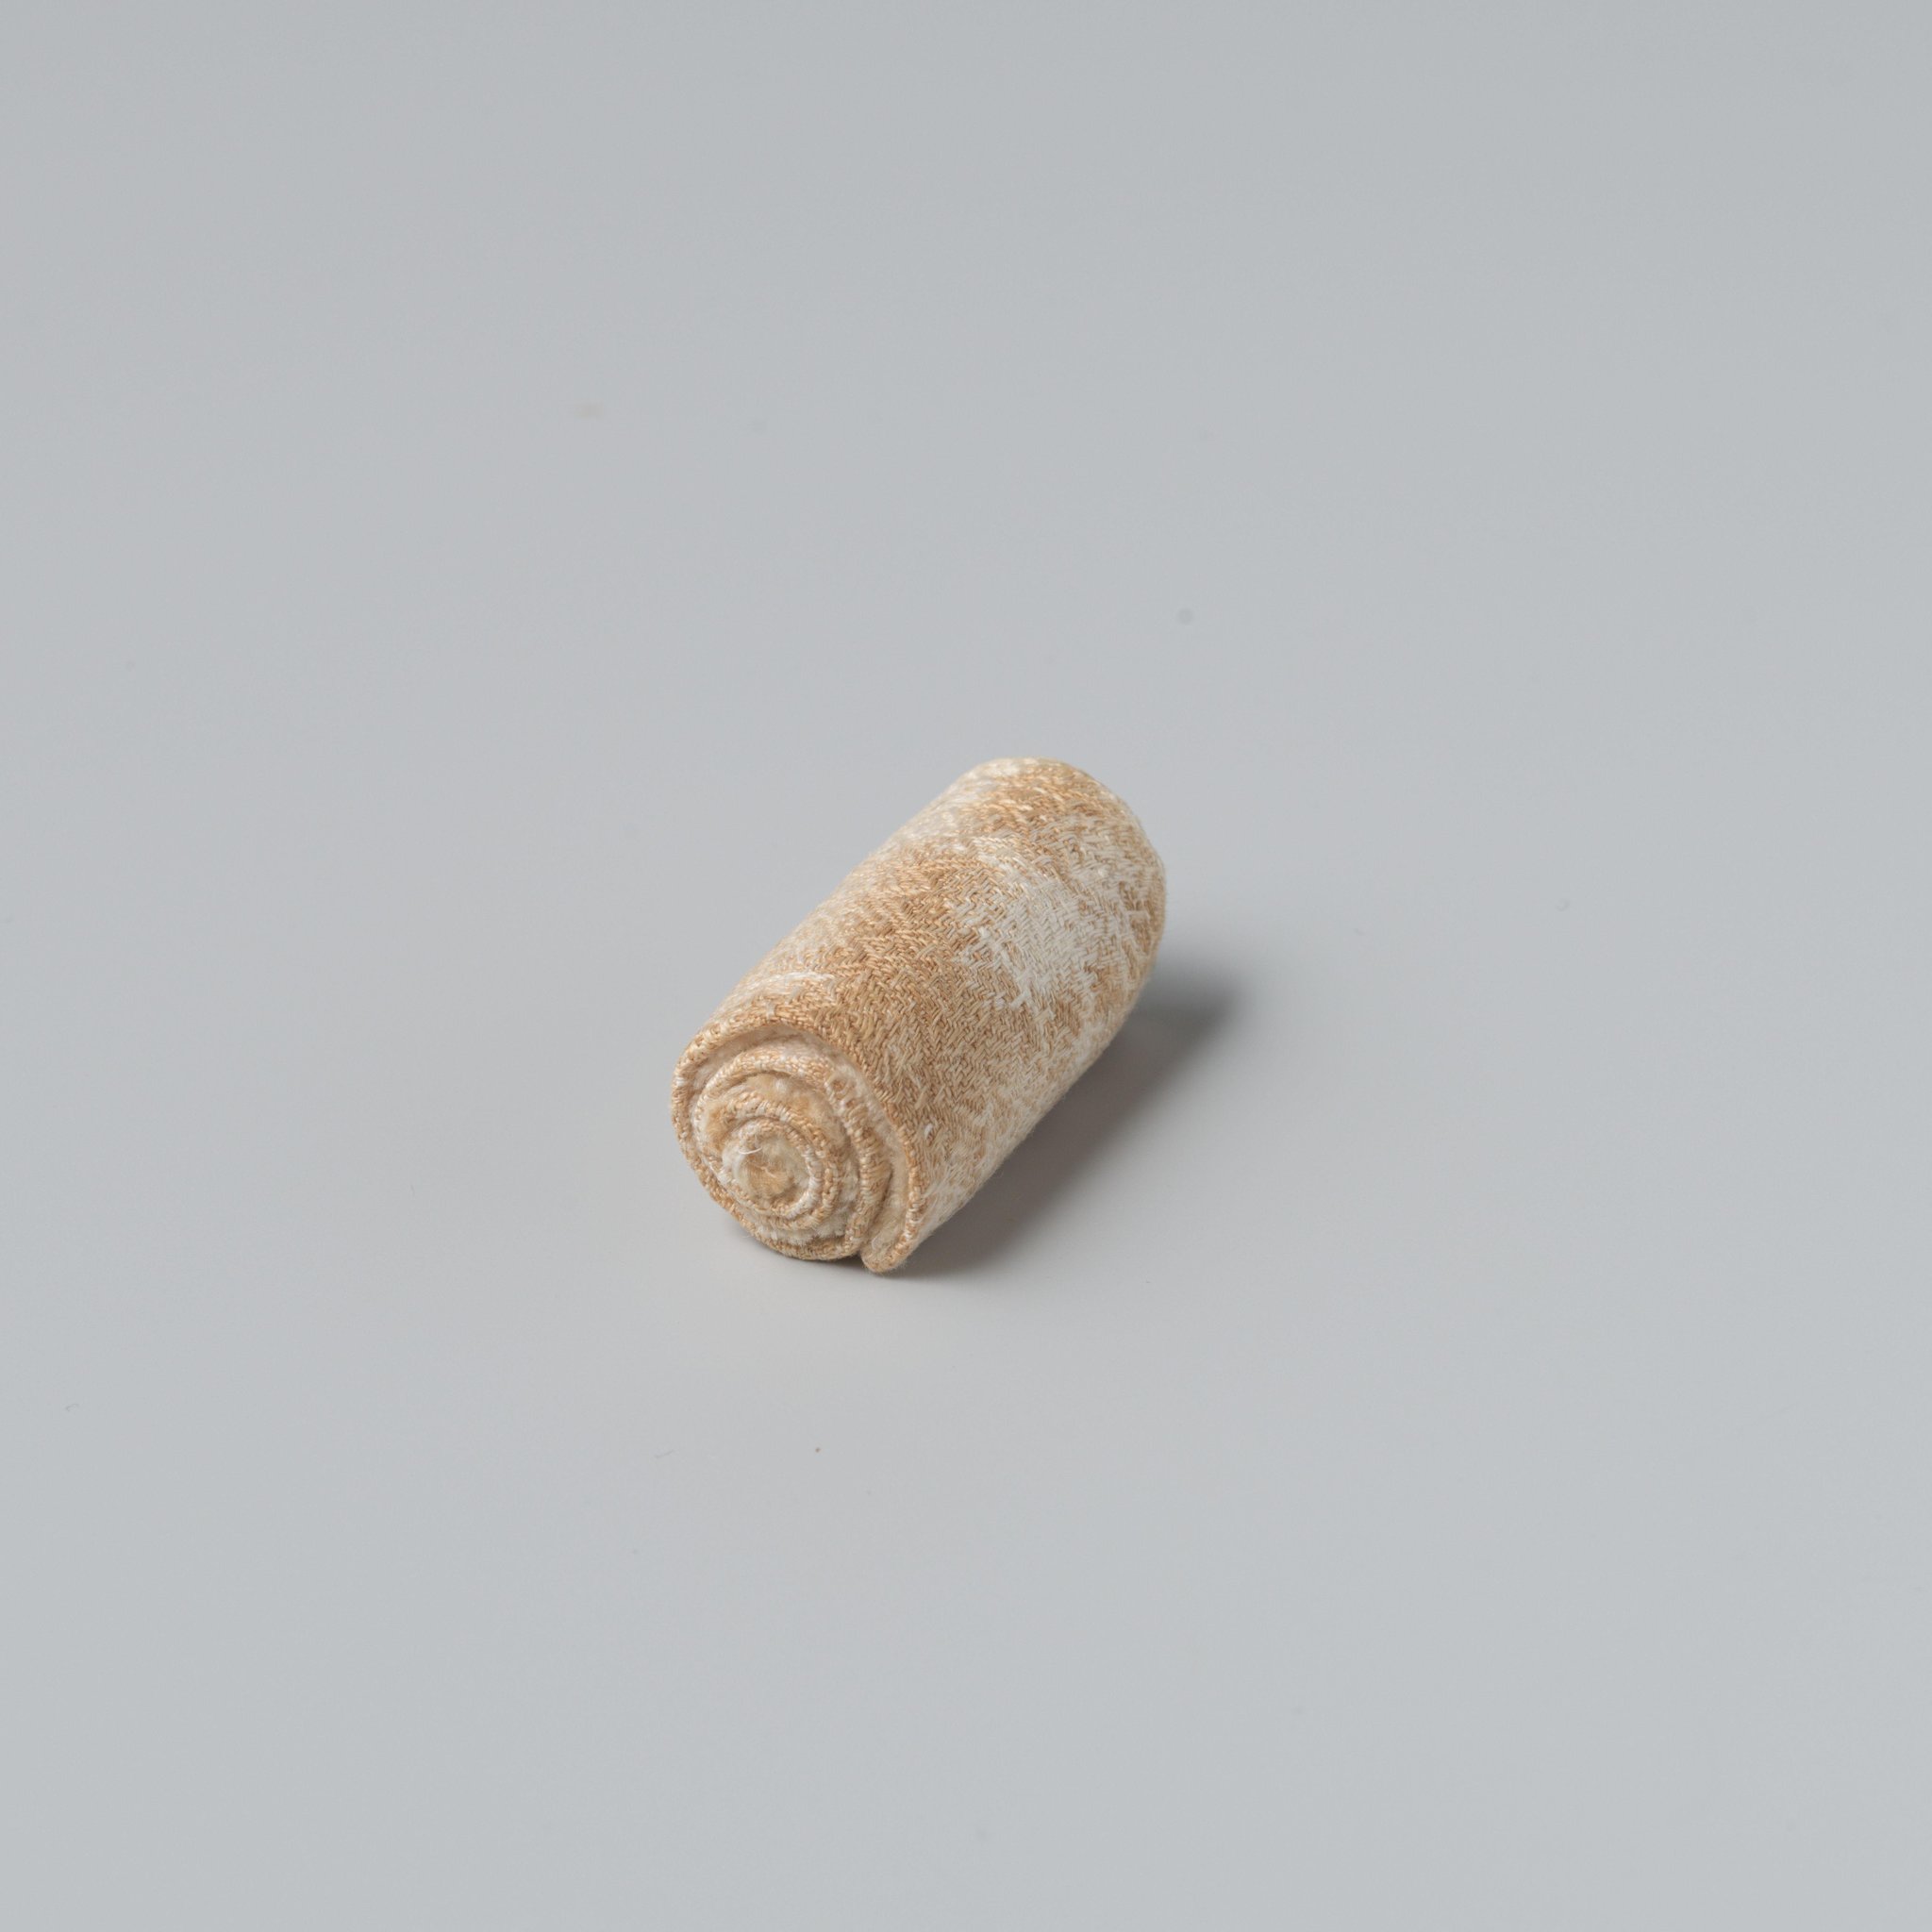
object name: rol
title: Rol linnen, damastweefsel met pellenpatroon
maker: Anonymous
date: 1600-1699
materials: linen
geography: netherlands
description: Rol linnen, damastweefsel met pellenpatroon.